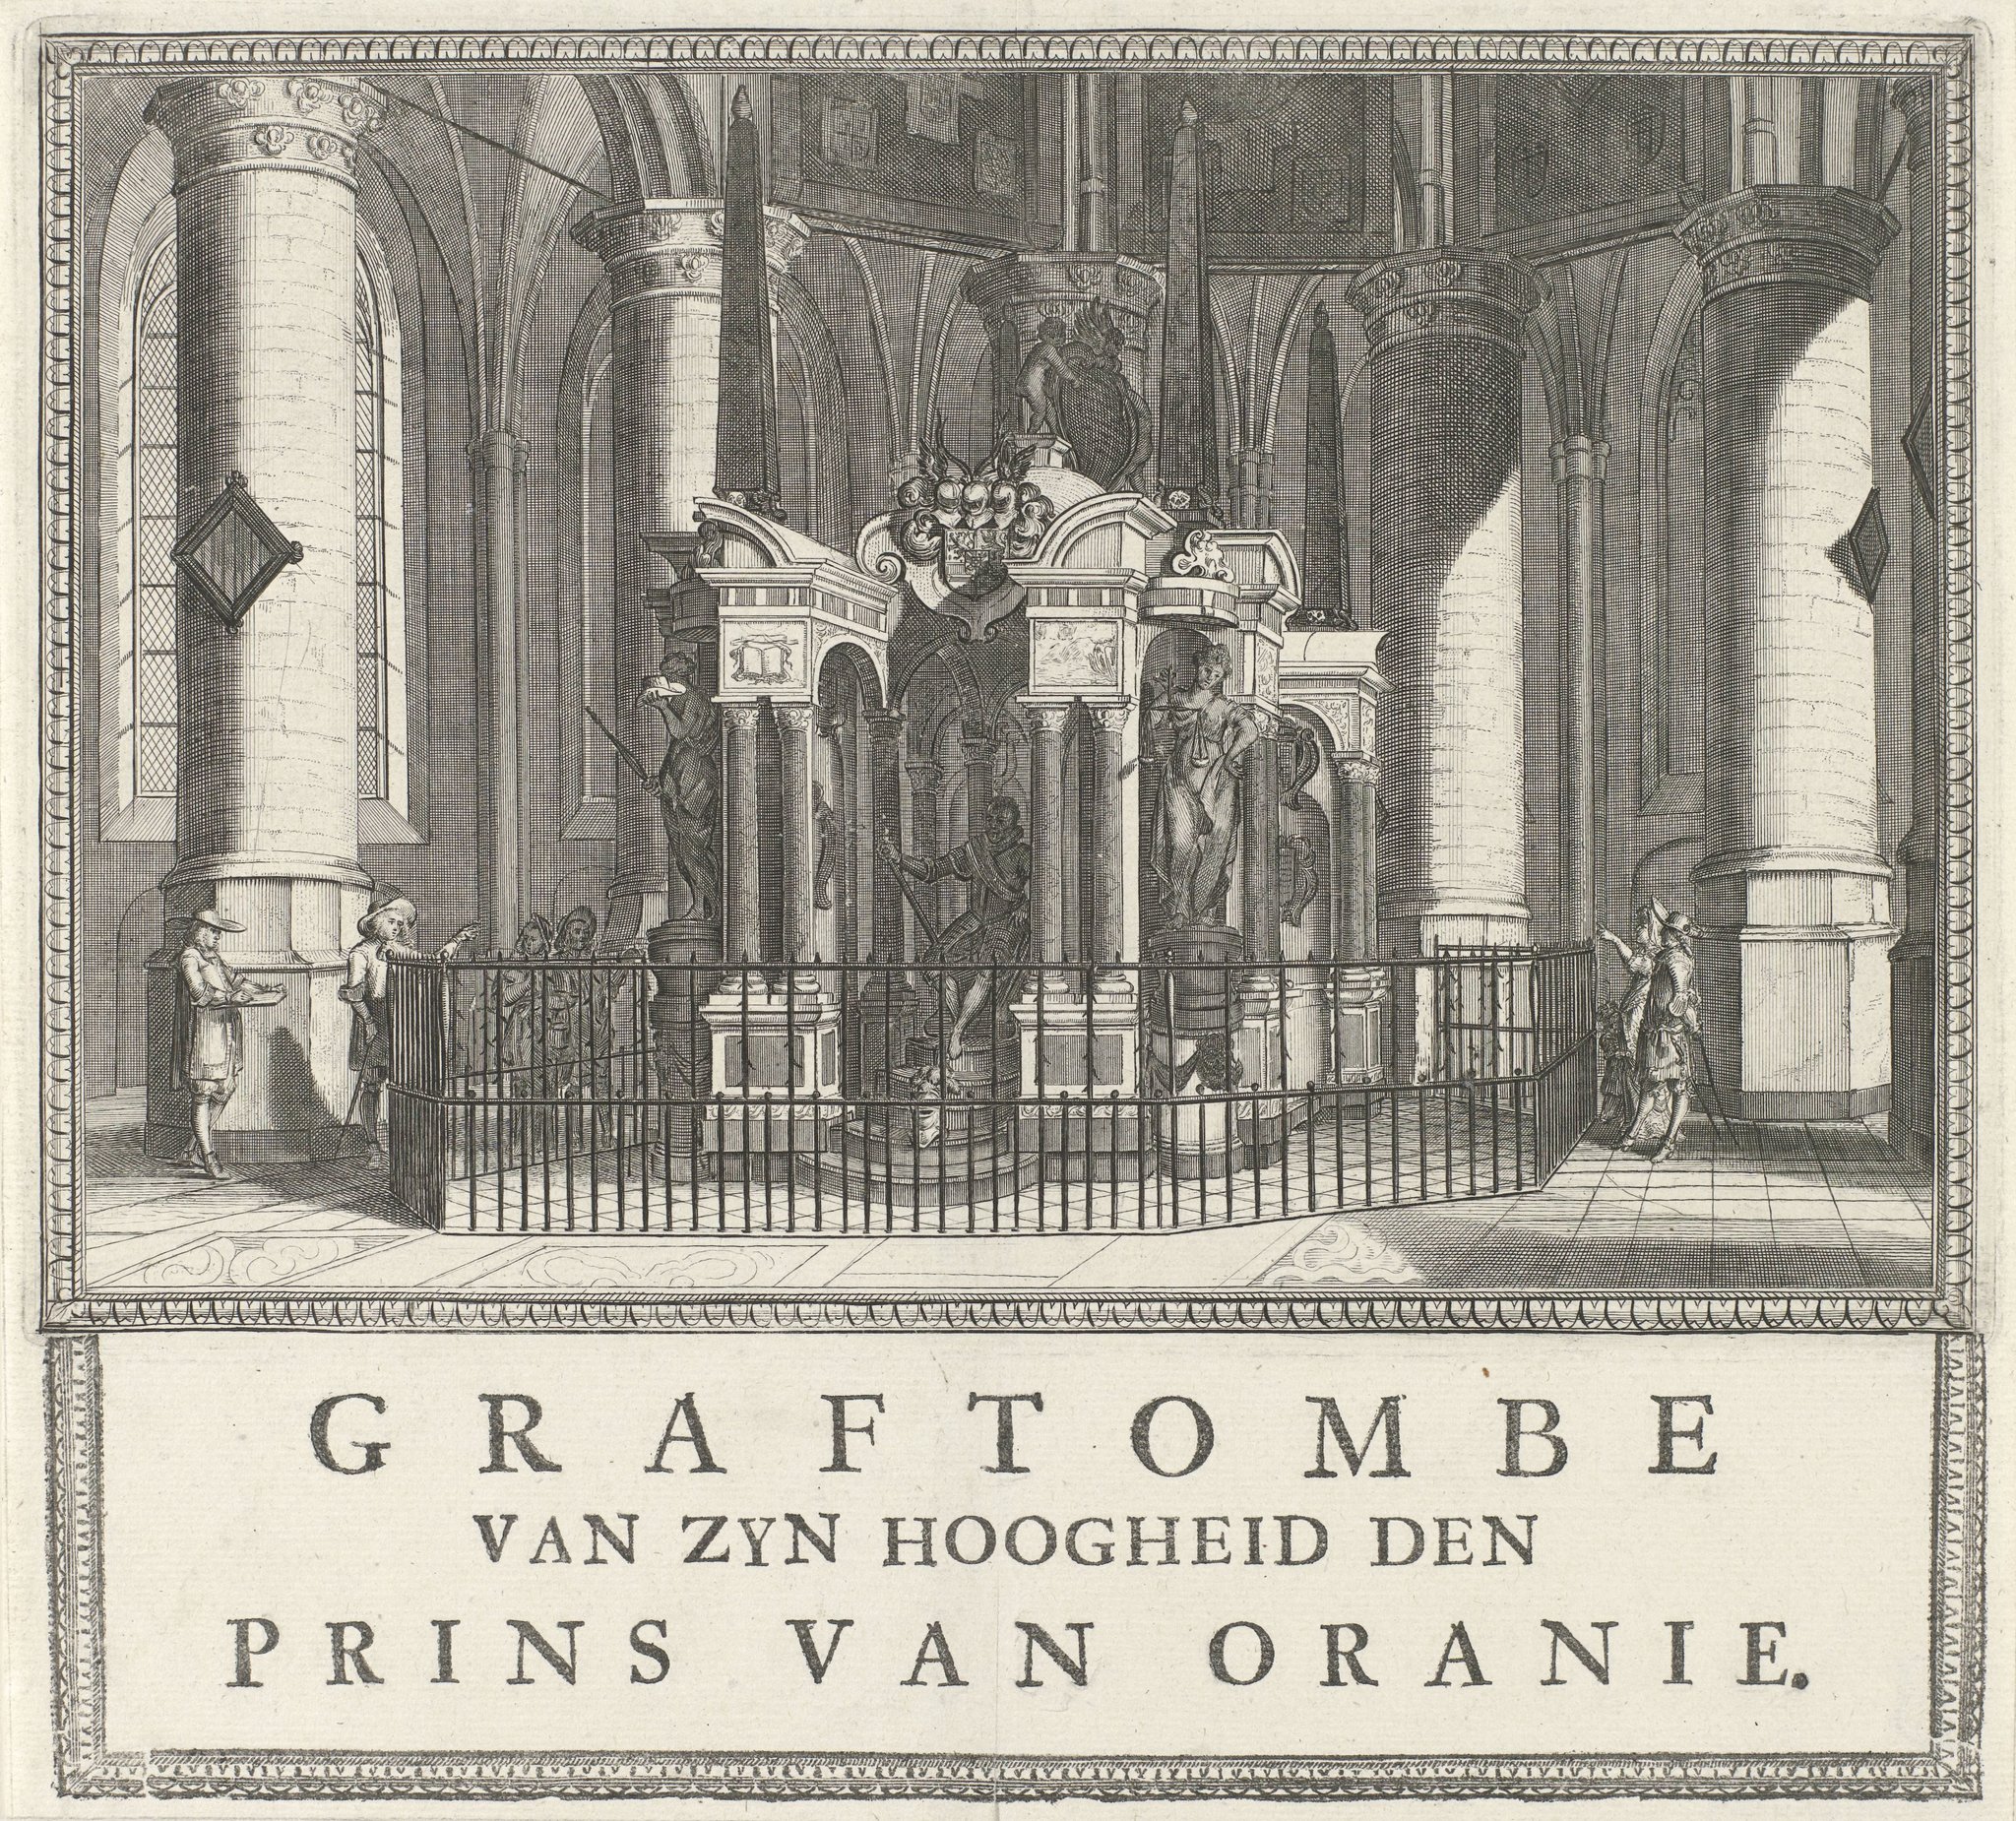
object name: print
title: Graftombe van zyn hoogheid den Prins van Oranie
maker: Anonymous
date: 1700-1799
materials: paper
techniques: etching, letterpress printing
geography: low countries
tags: delft, william i (prince of orange), historical persons, interior of church, grave-building, monumental tomb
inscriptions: collector's mark: Lugt 963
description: Graftombe of praalgraf van Willem I in de Nieuwe Kerk te Delft, voltooid in 1623. Gezien van voren met het beeld van de zittende prins. Met de omlijsting en met een apart gedrukte titel tegen de onderzijde van de voorstelling.